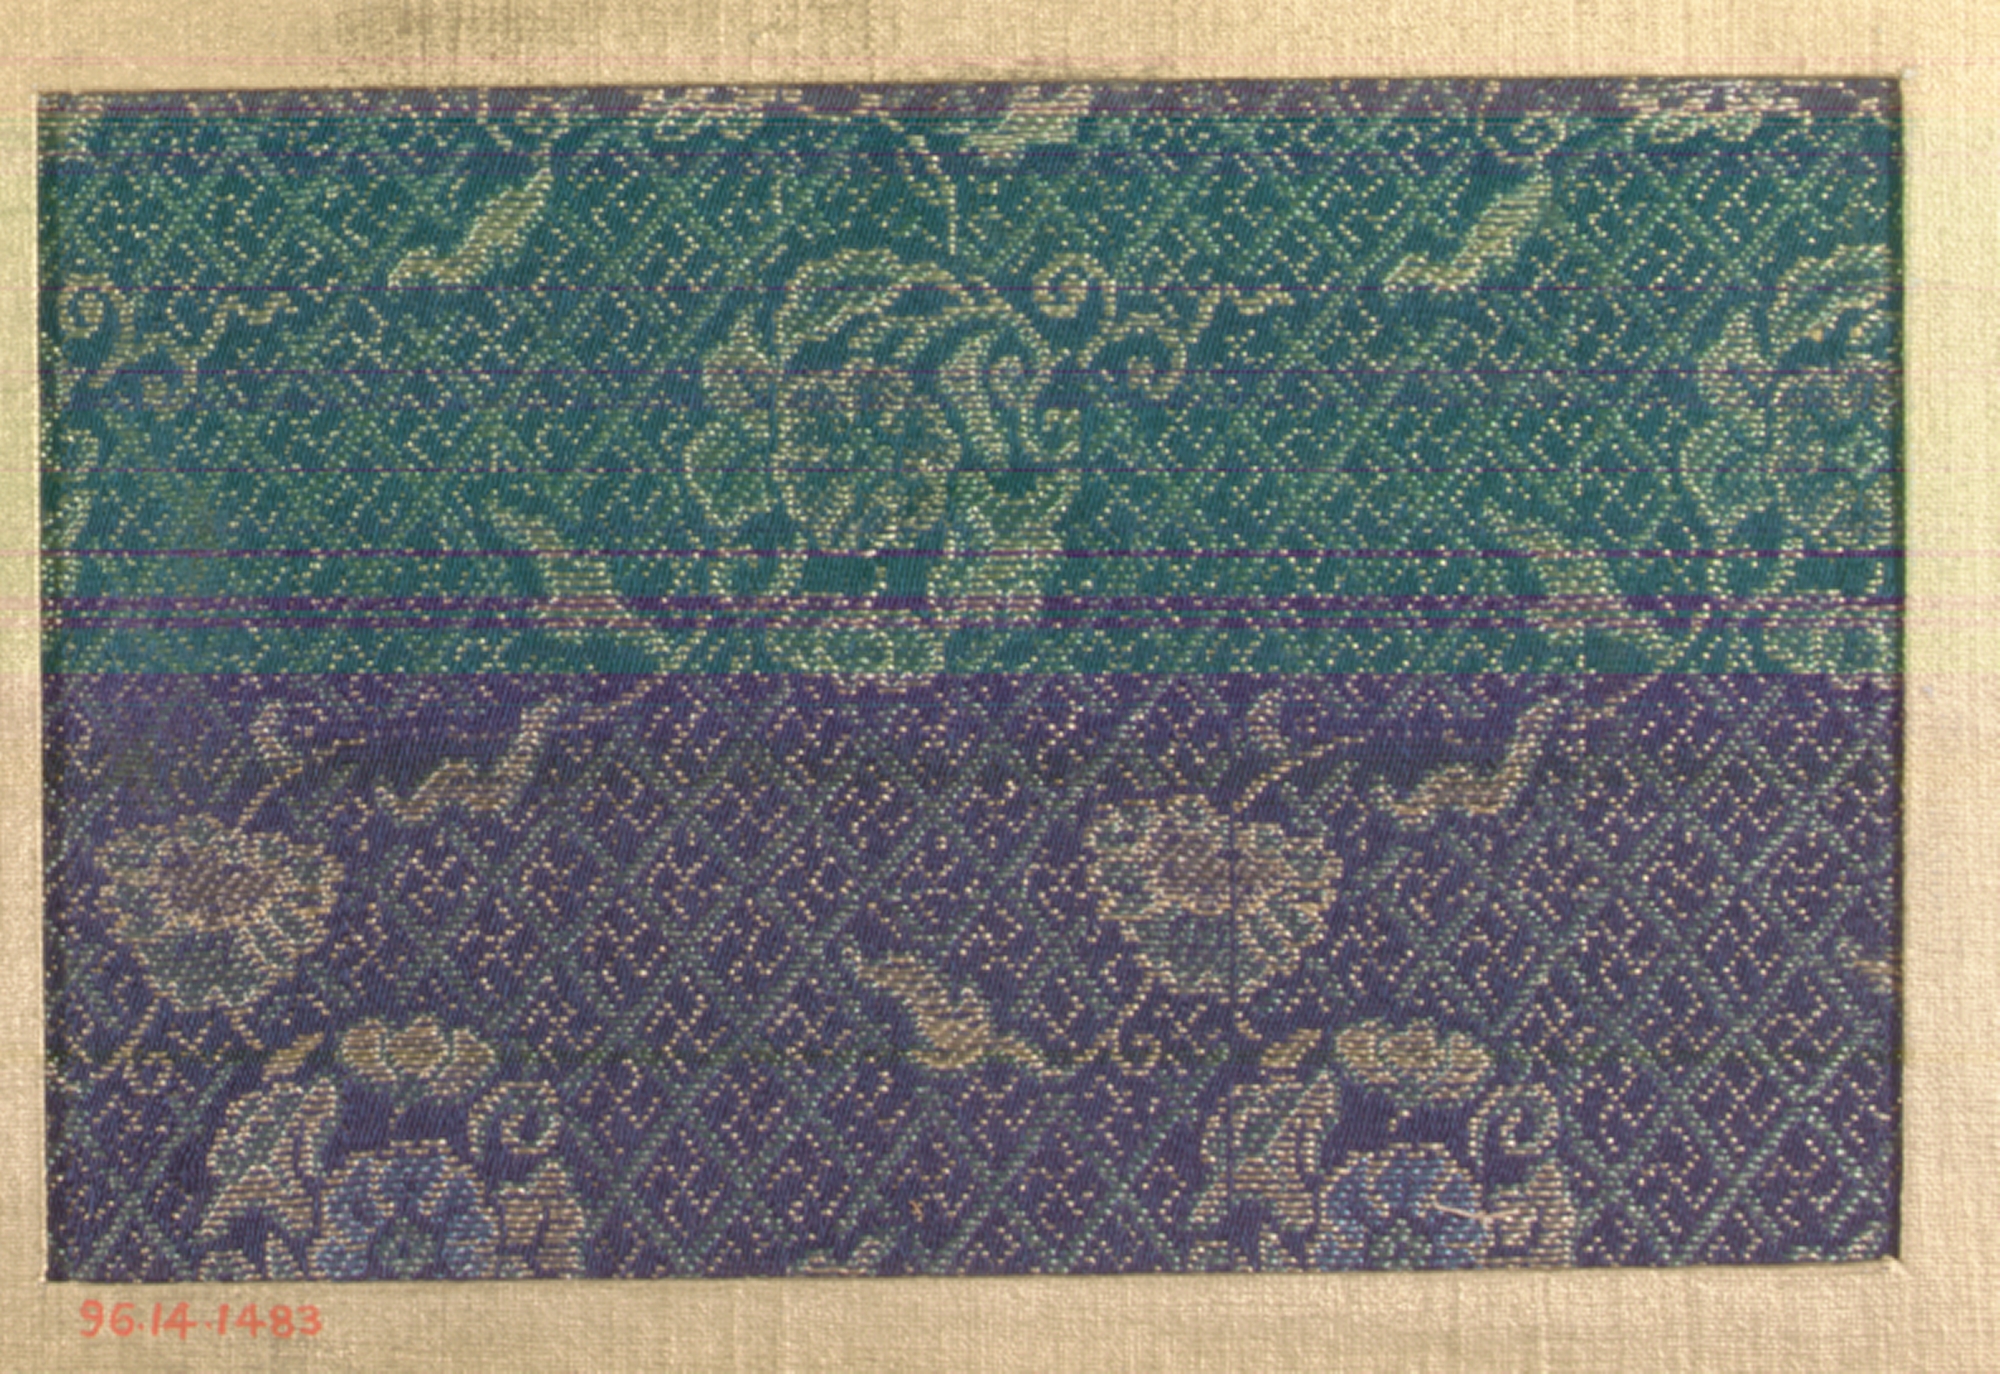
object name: piece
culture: japanese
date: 1701-1900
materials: silk